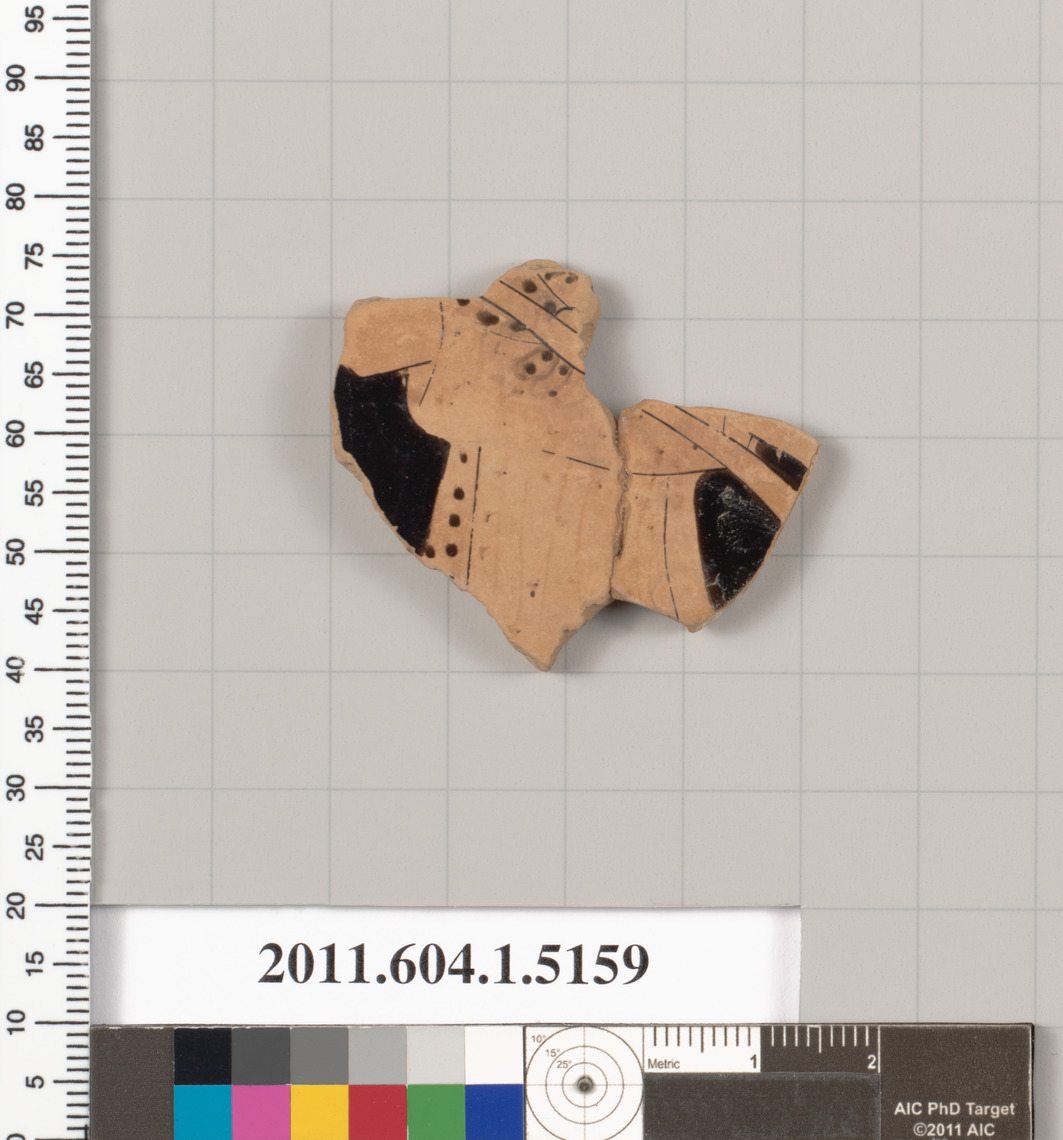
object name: kylix fragment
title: Terracotta fragment of a kylix (drinking cup)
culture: greek, attic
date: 490-480 BCE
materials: terracotta